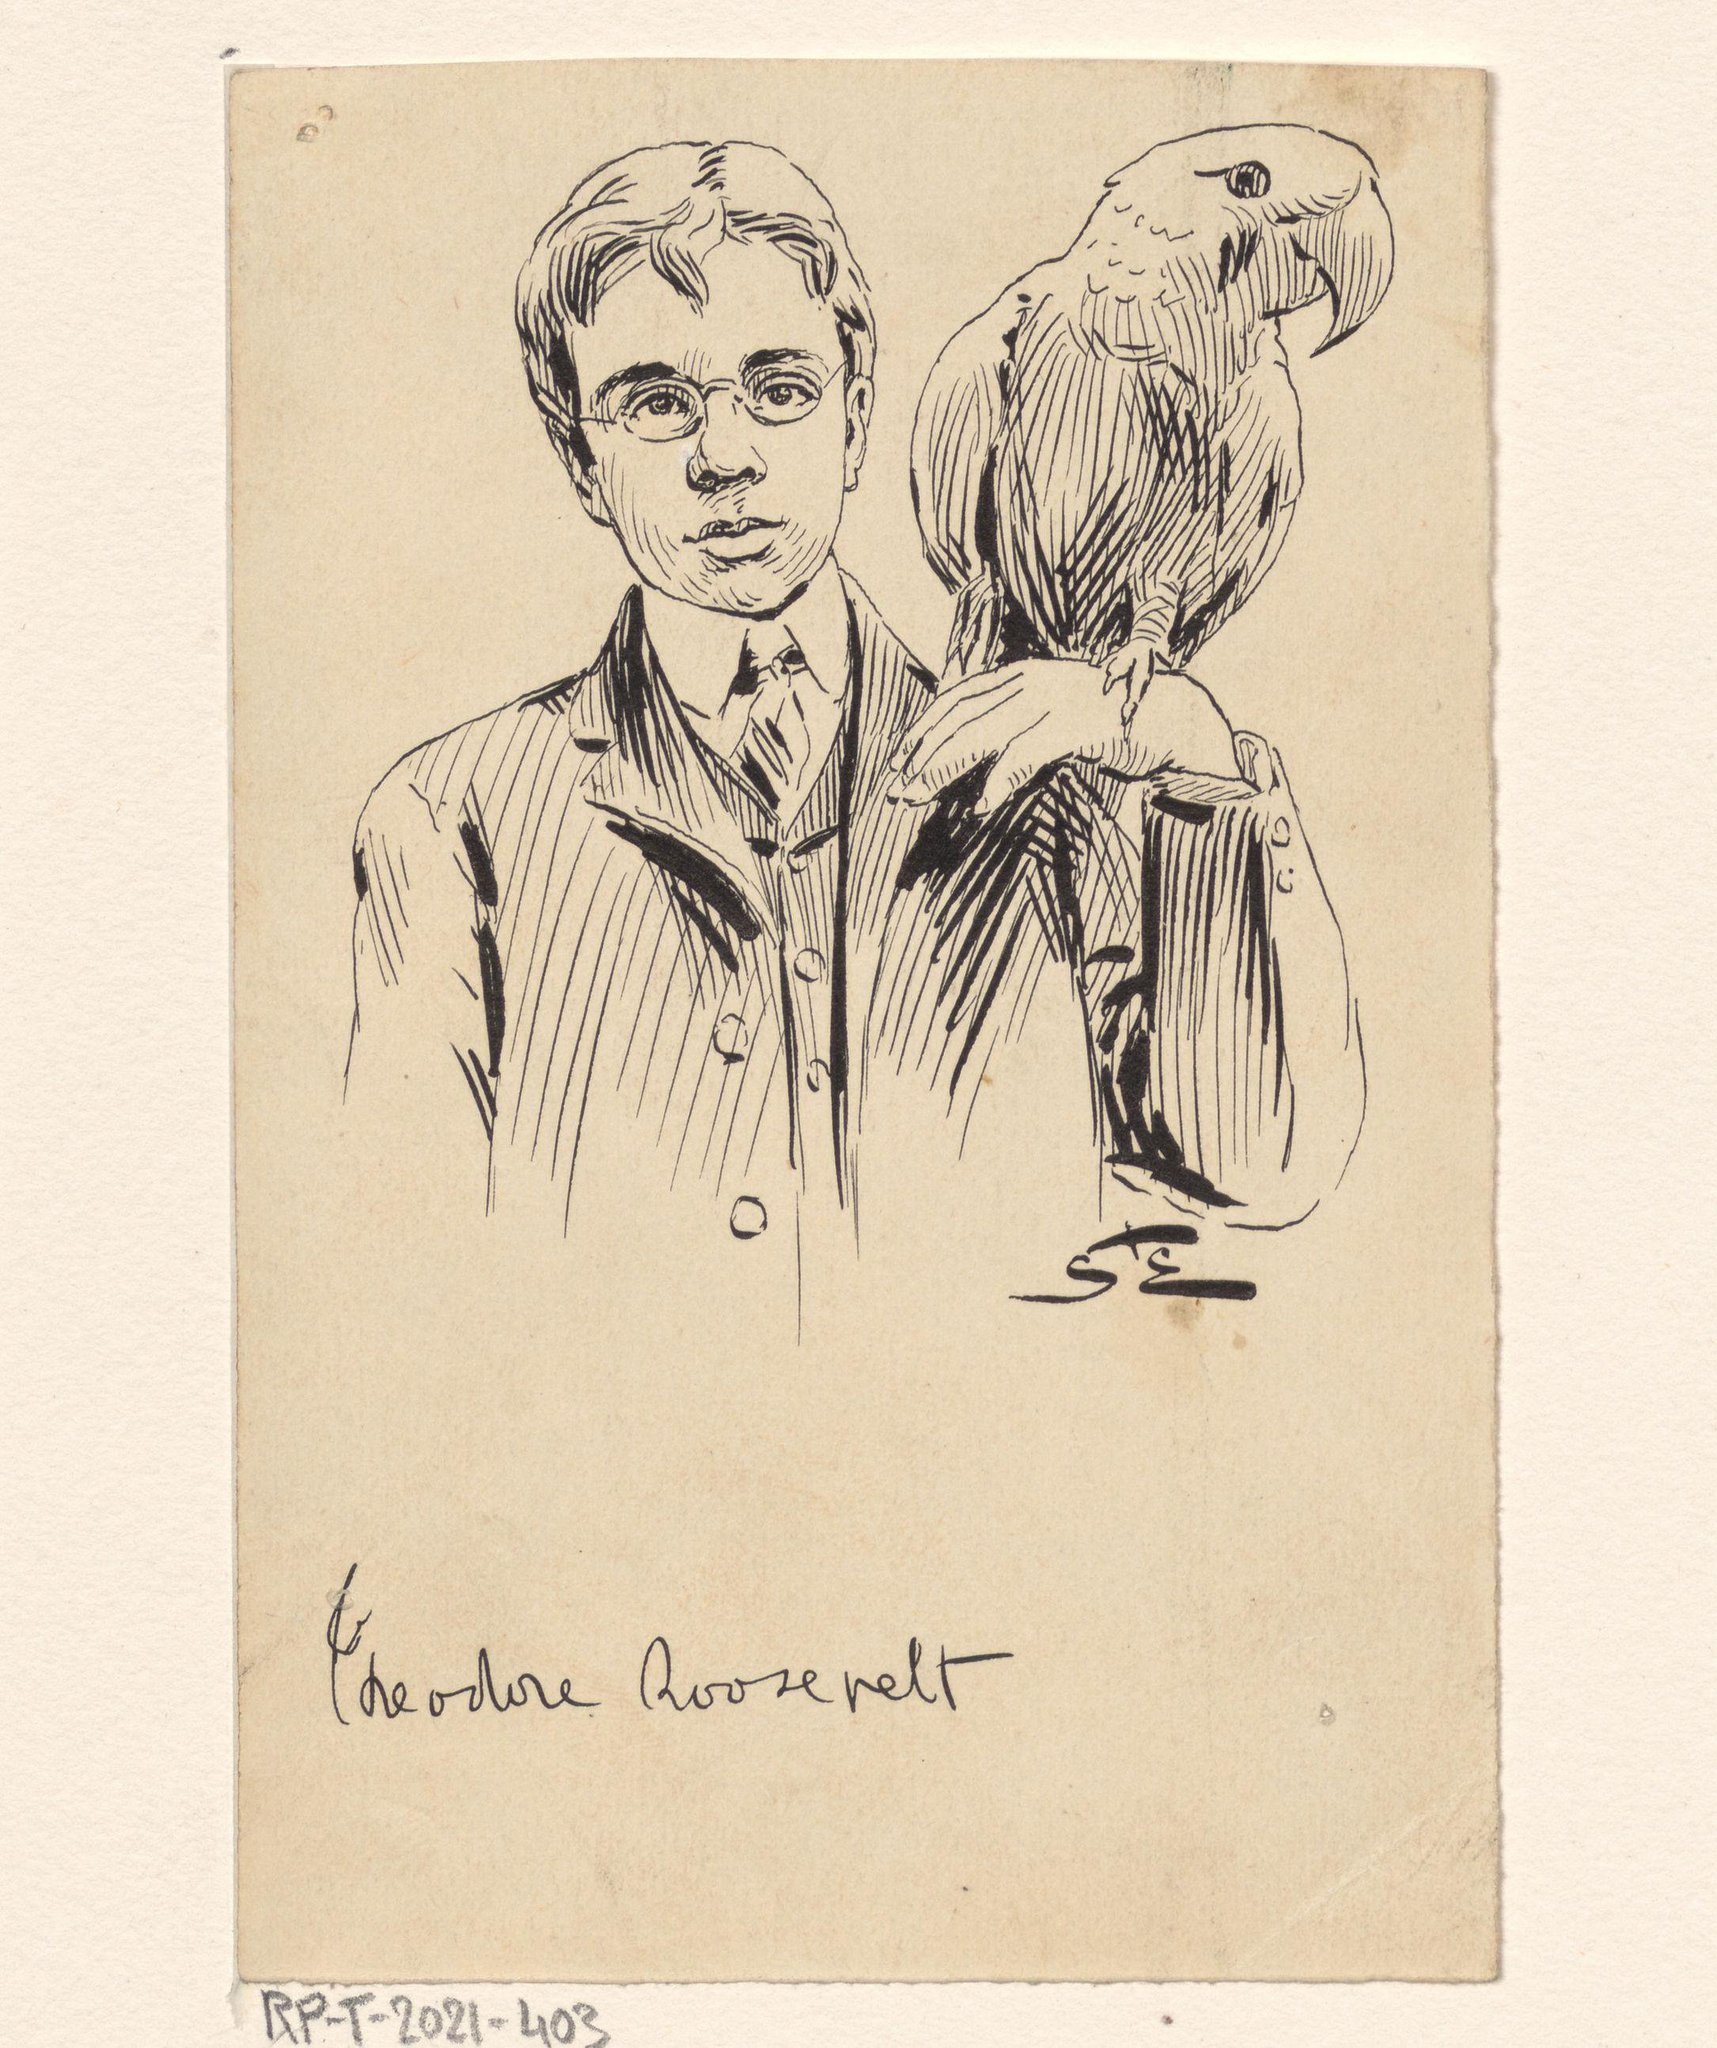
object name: drawing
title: Portret van Theodore Roosevelt met Eli de blauwe ara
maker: Anonymous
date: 1902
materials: ink, paper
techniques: pen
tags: new york (city), politician, ornamental birds: parrot, historical persons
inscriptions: signature: ‘STE’